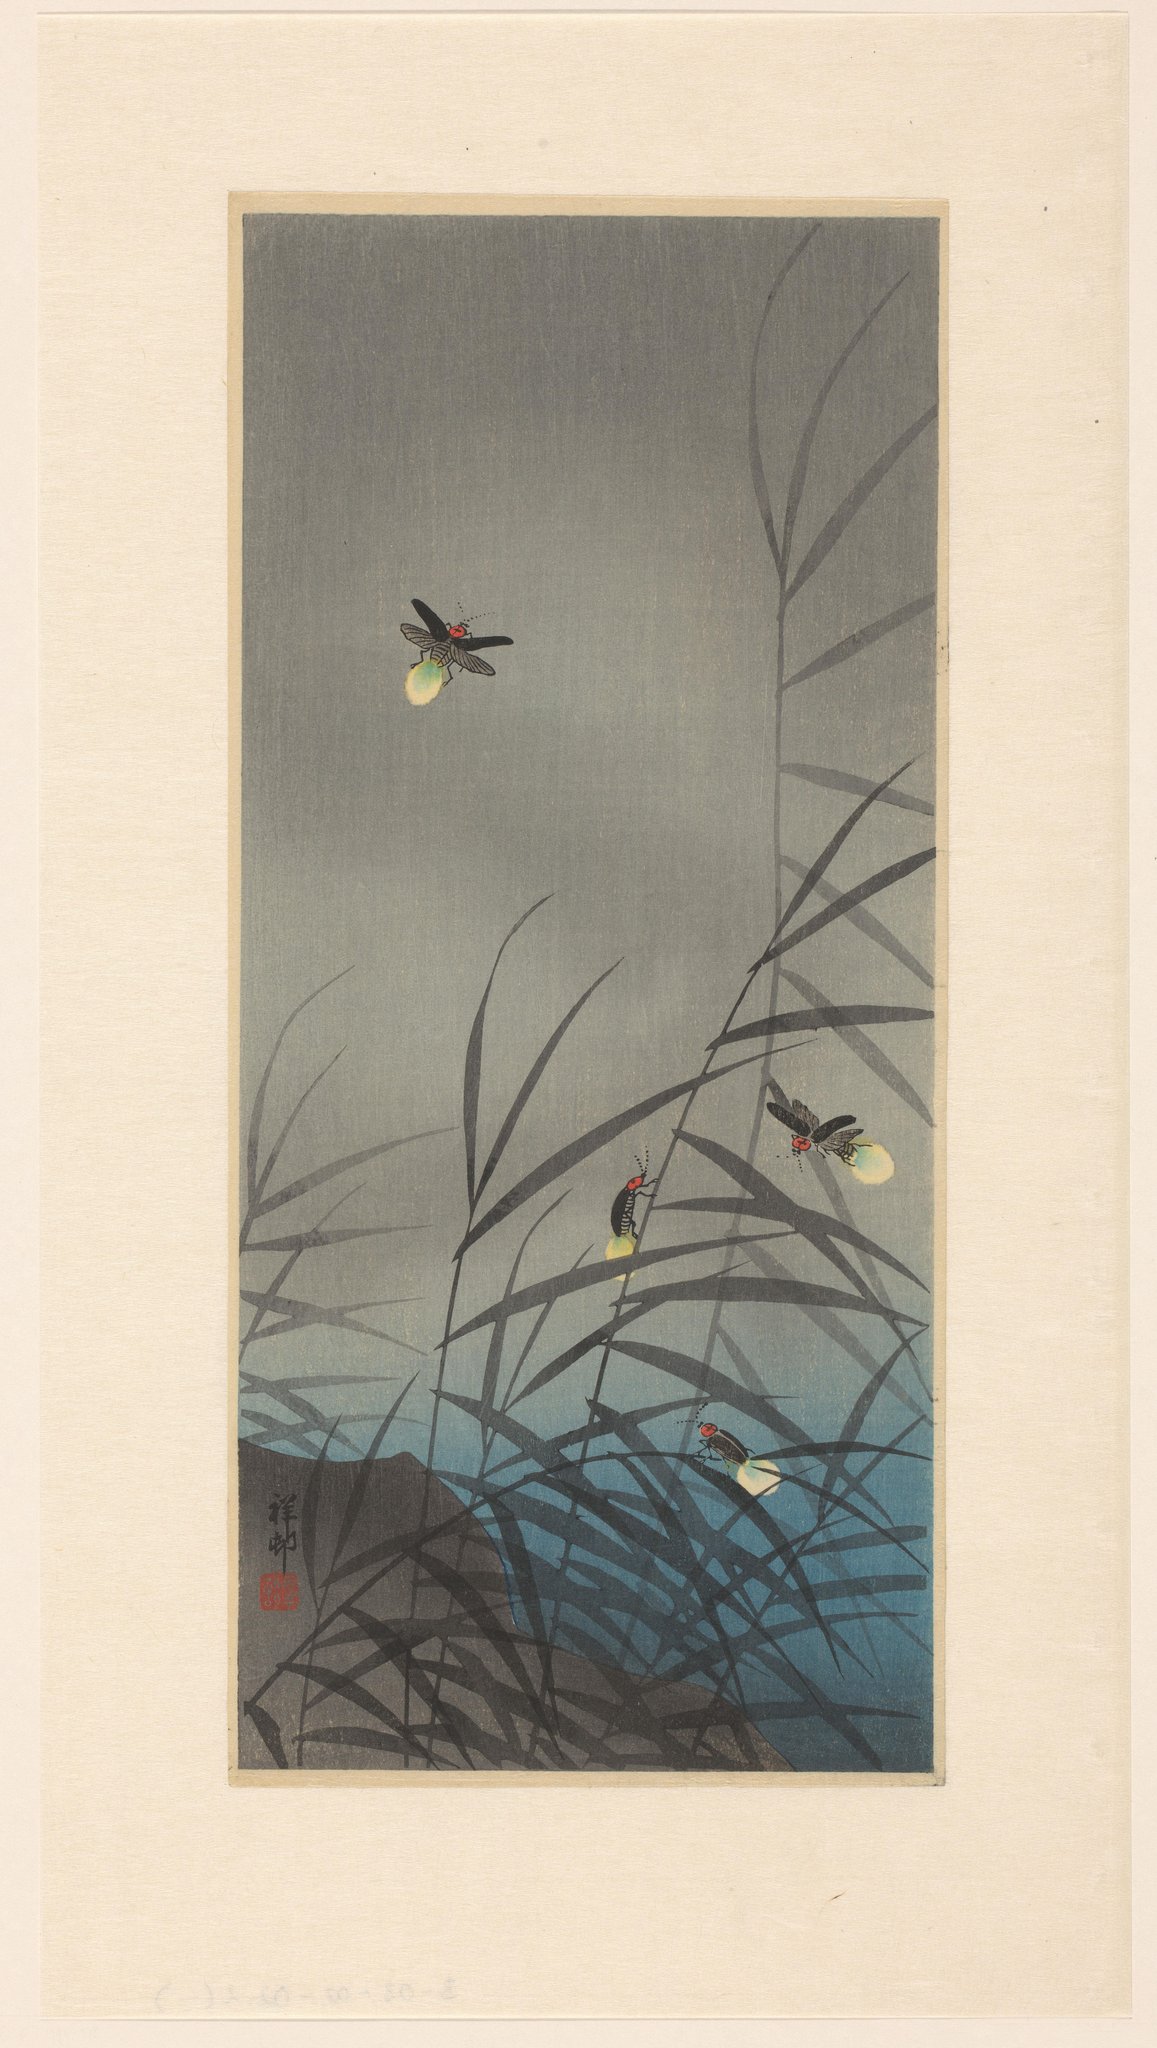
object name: print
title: Vuurvliegjes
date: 1925-1936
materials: paper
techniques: woodcut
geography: tokyo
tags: plants and herbs: reed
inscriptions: collector's mark: Lugt 2228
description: Vier vuurvliegjes tussen riet, bij water.